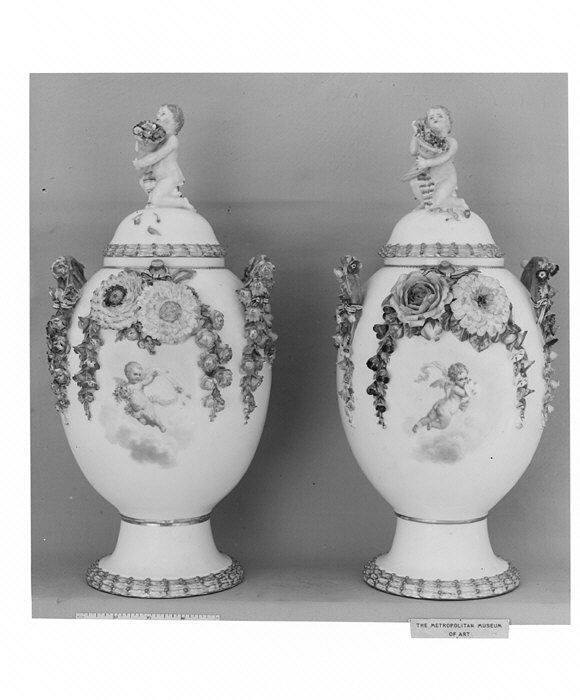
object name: vase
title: Pair of vases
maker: royal porcelain manufactory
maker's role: factory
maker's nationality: danish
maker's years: 1775-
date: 1880-1890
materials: hard paste porcelain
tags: putti,flowers,roses